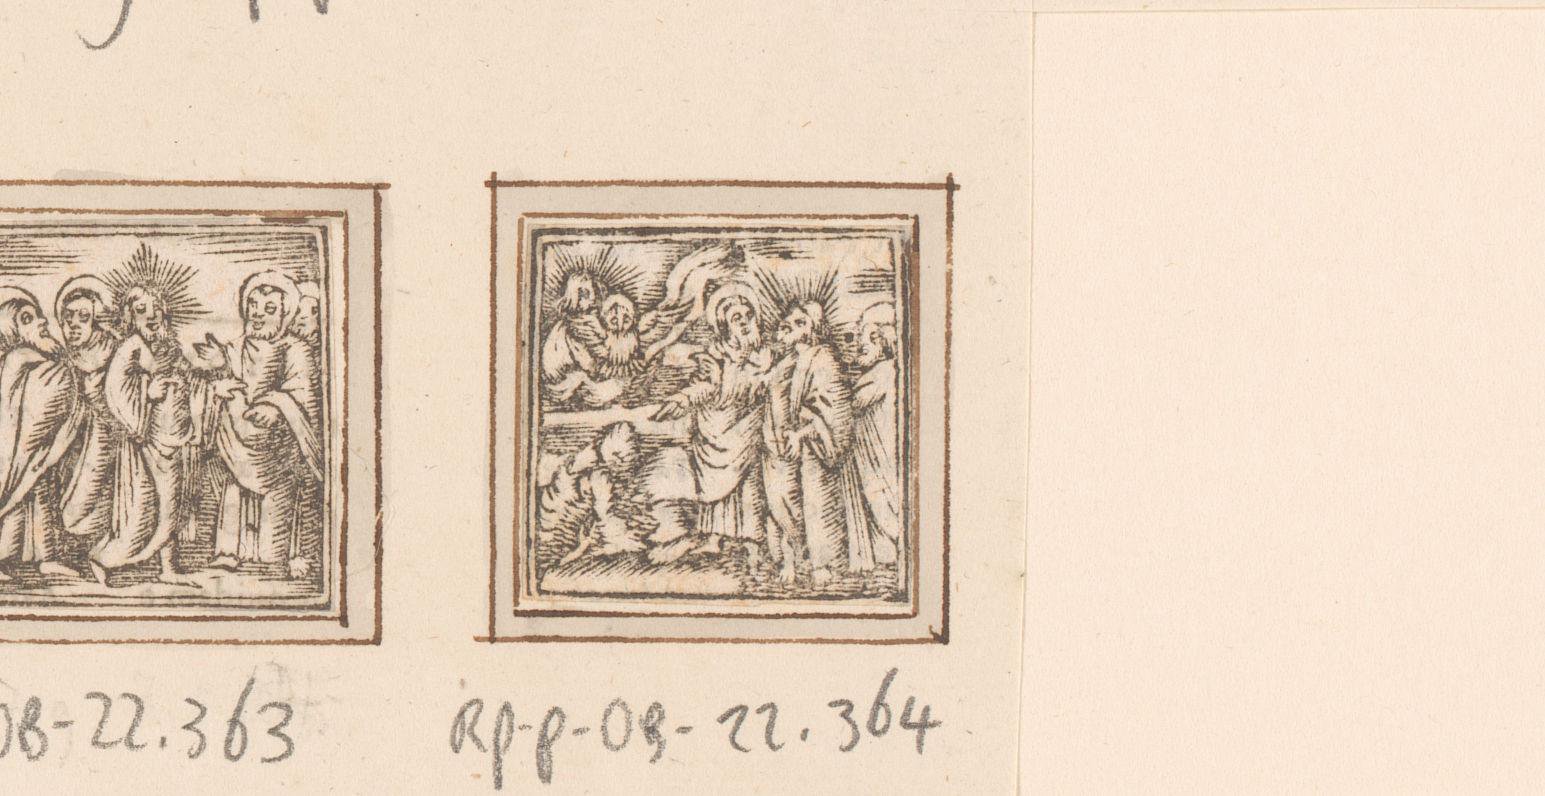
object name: print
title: Bijbelillustraties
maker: Anonymous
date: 1590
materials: paper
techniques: woodcut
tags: representations of the trinity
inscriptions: collector's mark: Lugt 240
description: Prent afkomstig uit een onbekende Latijnse bijbel, mogelijk gedateerd 1590.